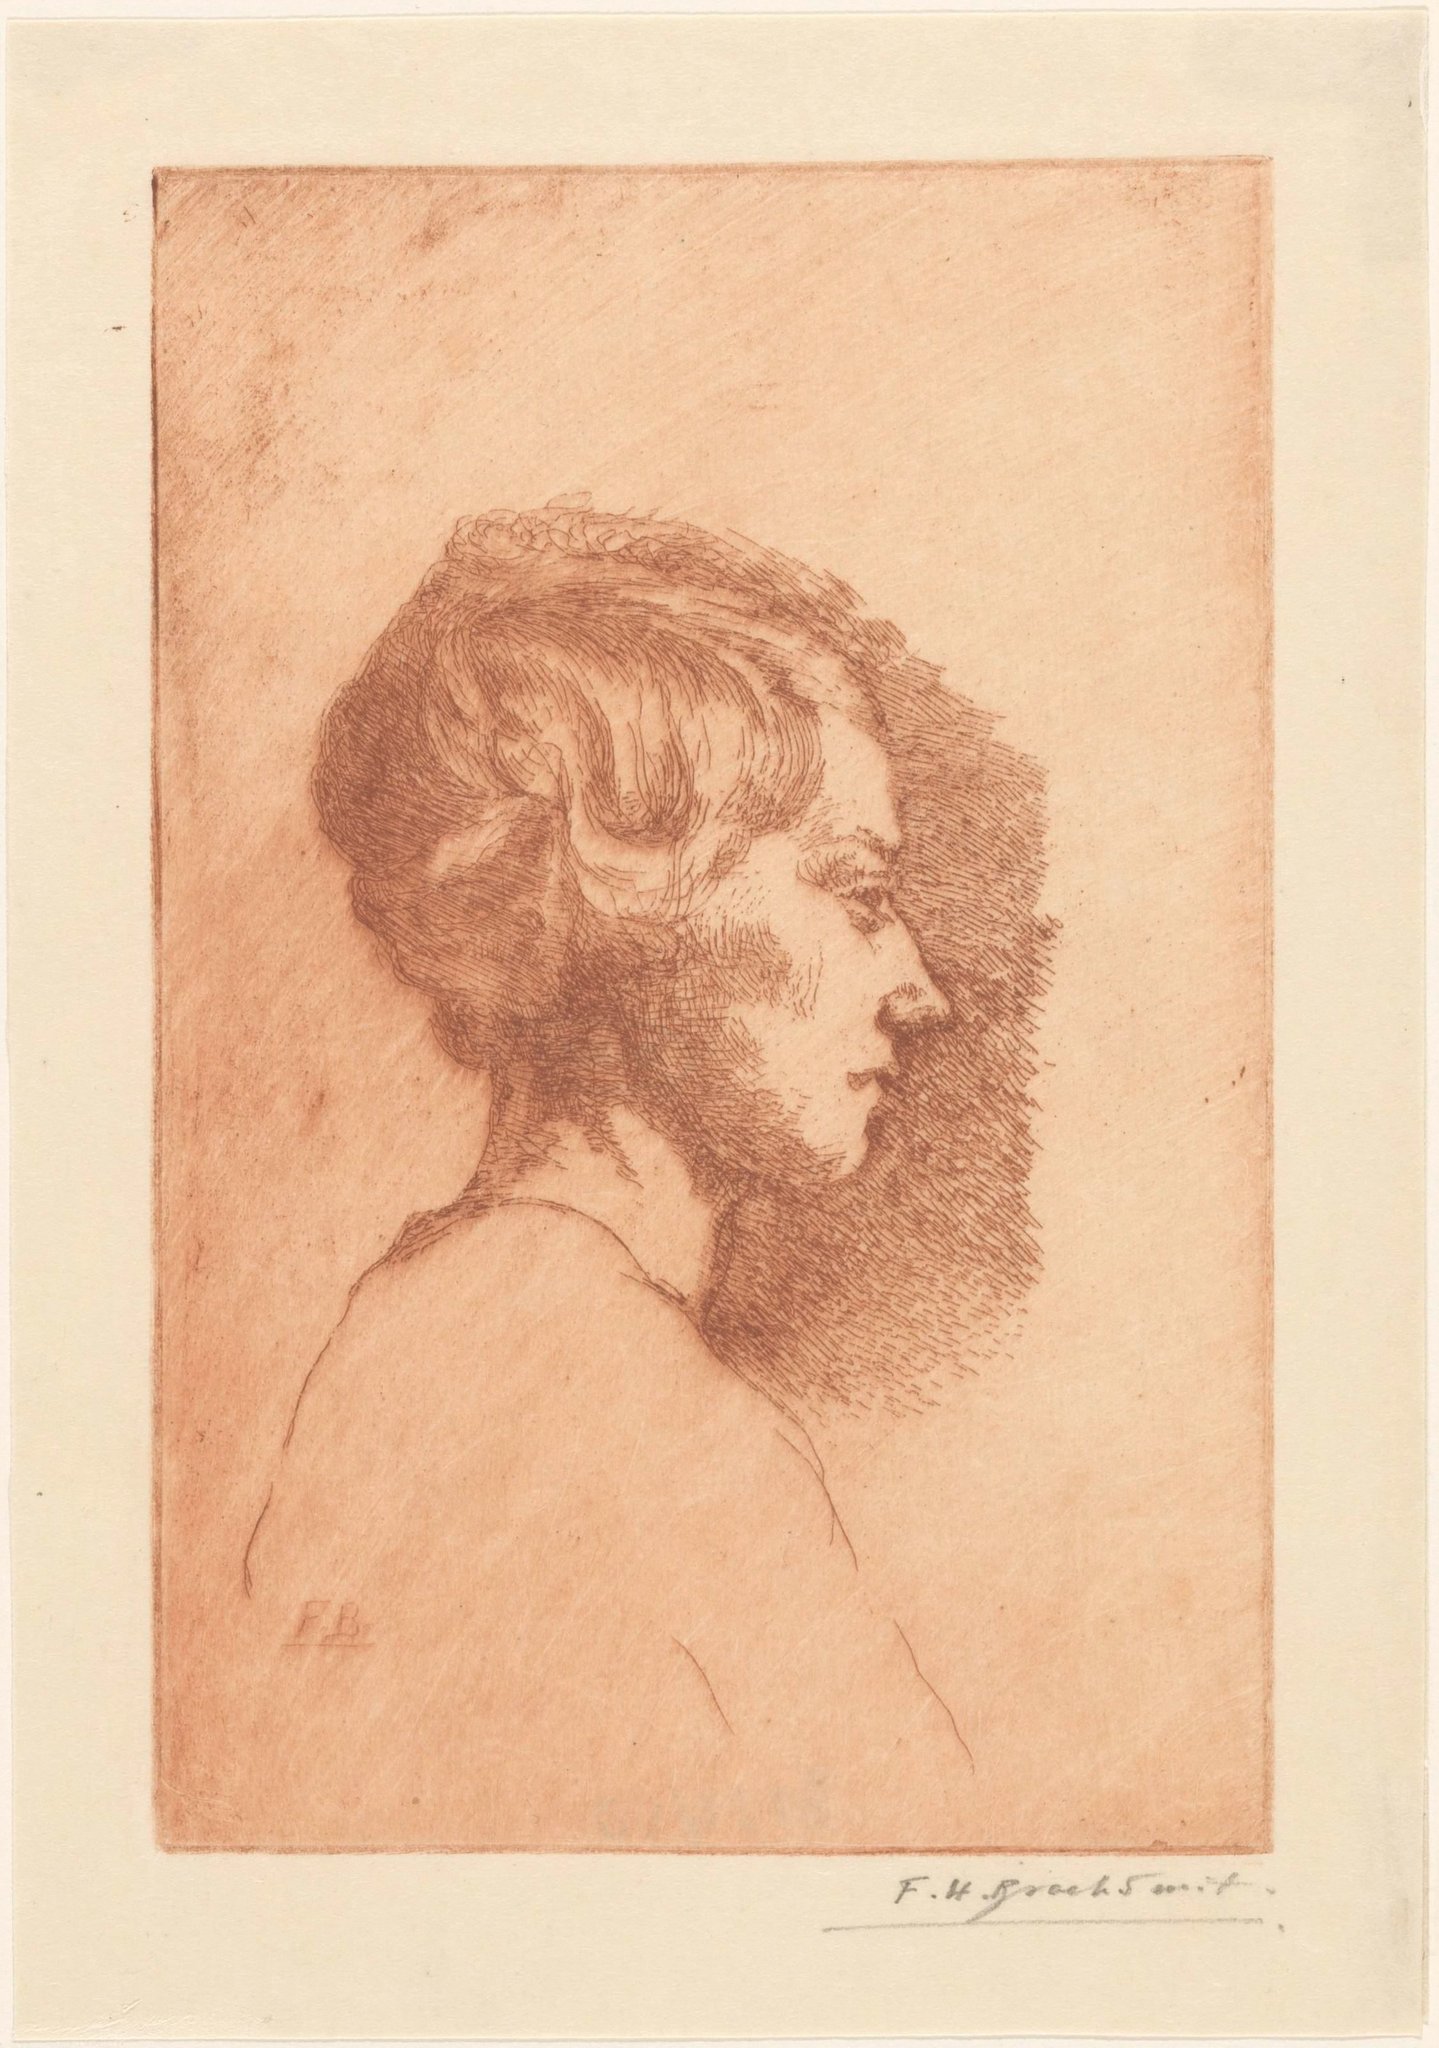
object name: print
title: Portret van een onbekende vrouw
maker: frederika henriëtte broeksmit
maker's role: draughtsman, print maker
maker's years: 1875-1945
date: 1885-1931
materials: paper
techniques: etching, intaglio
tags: anonymous historical person portrayed alone - bb - woman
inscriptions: collector's mark: Lugt 2228